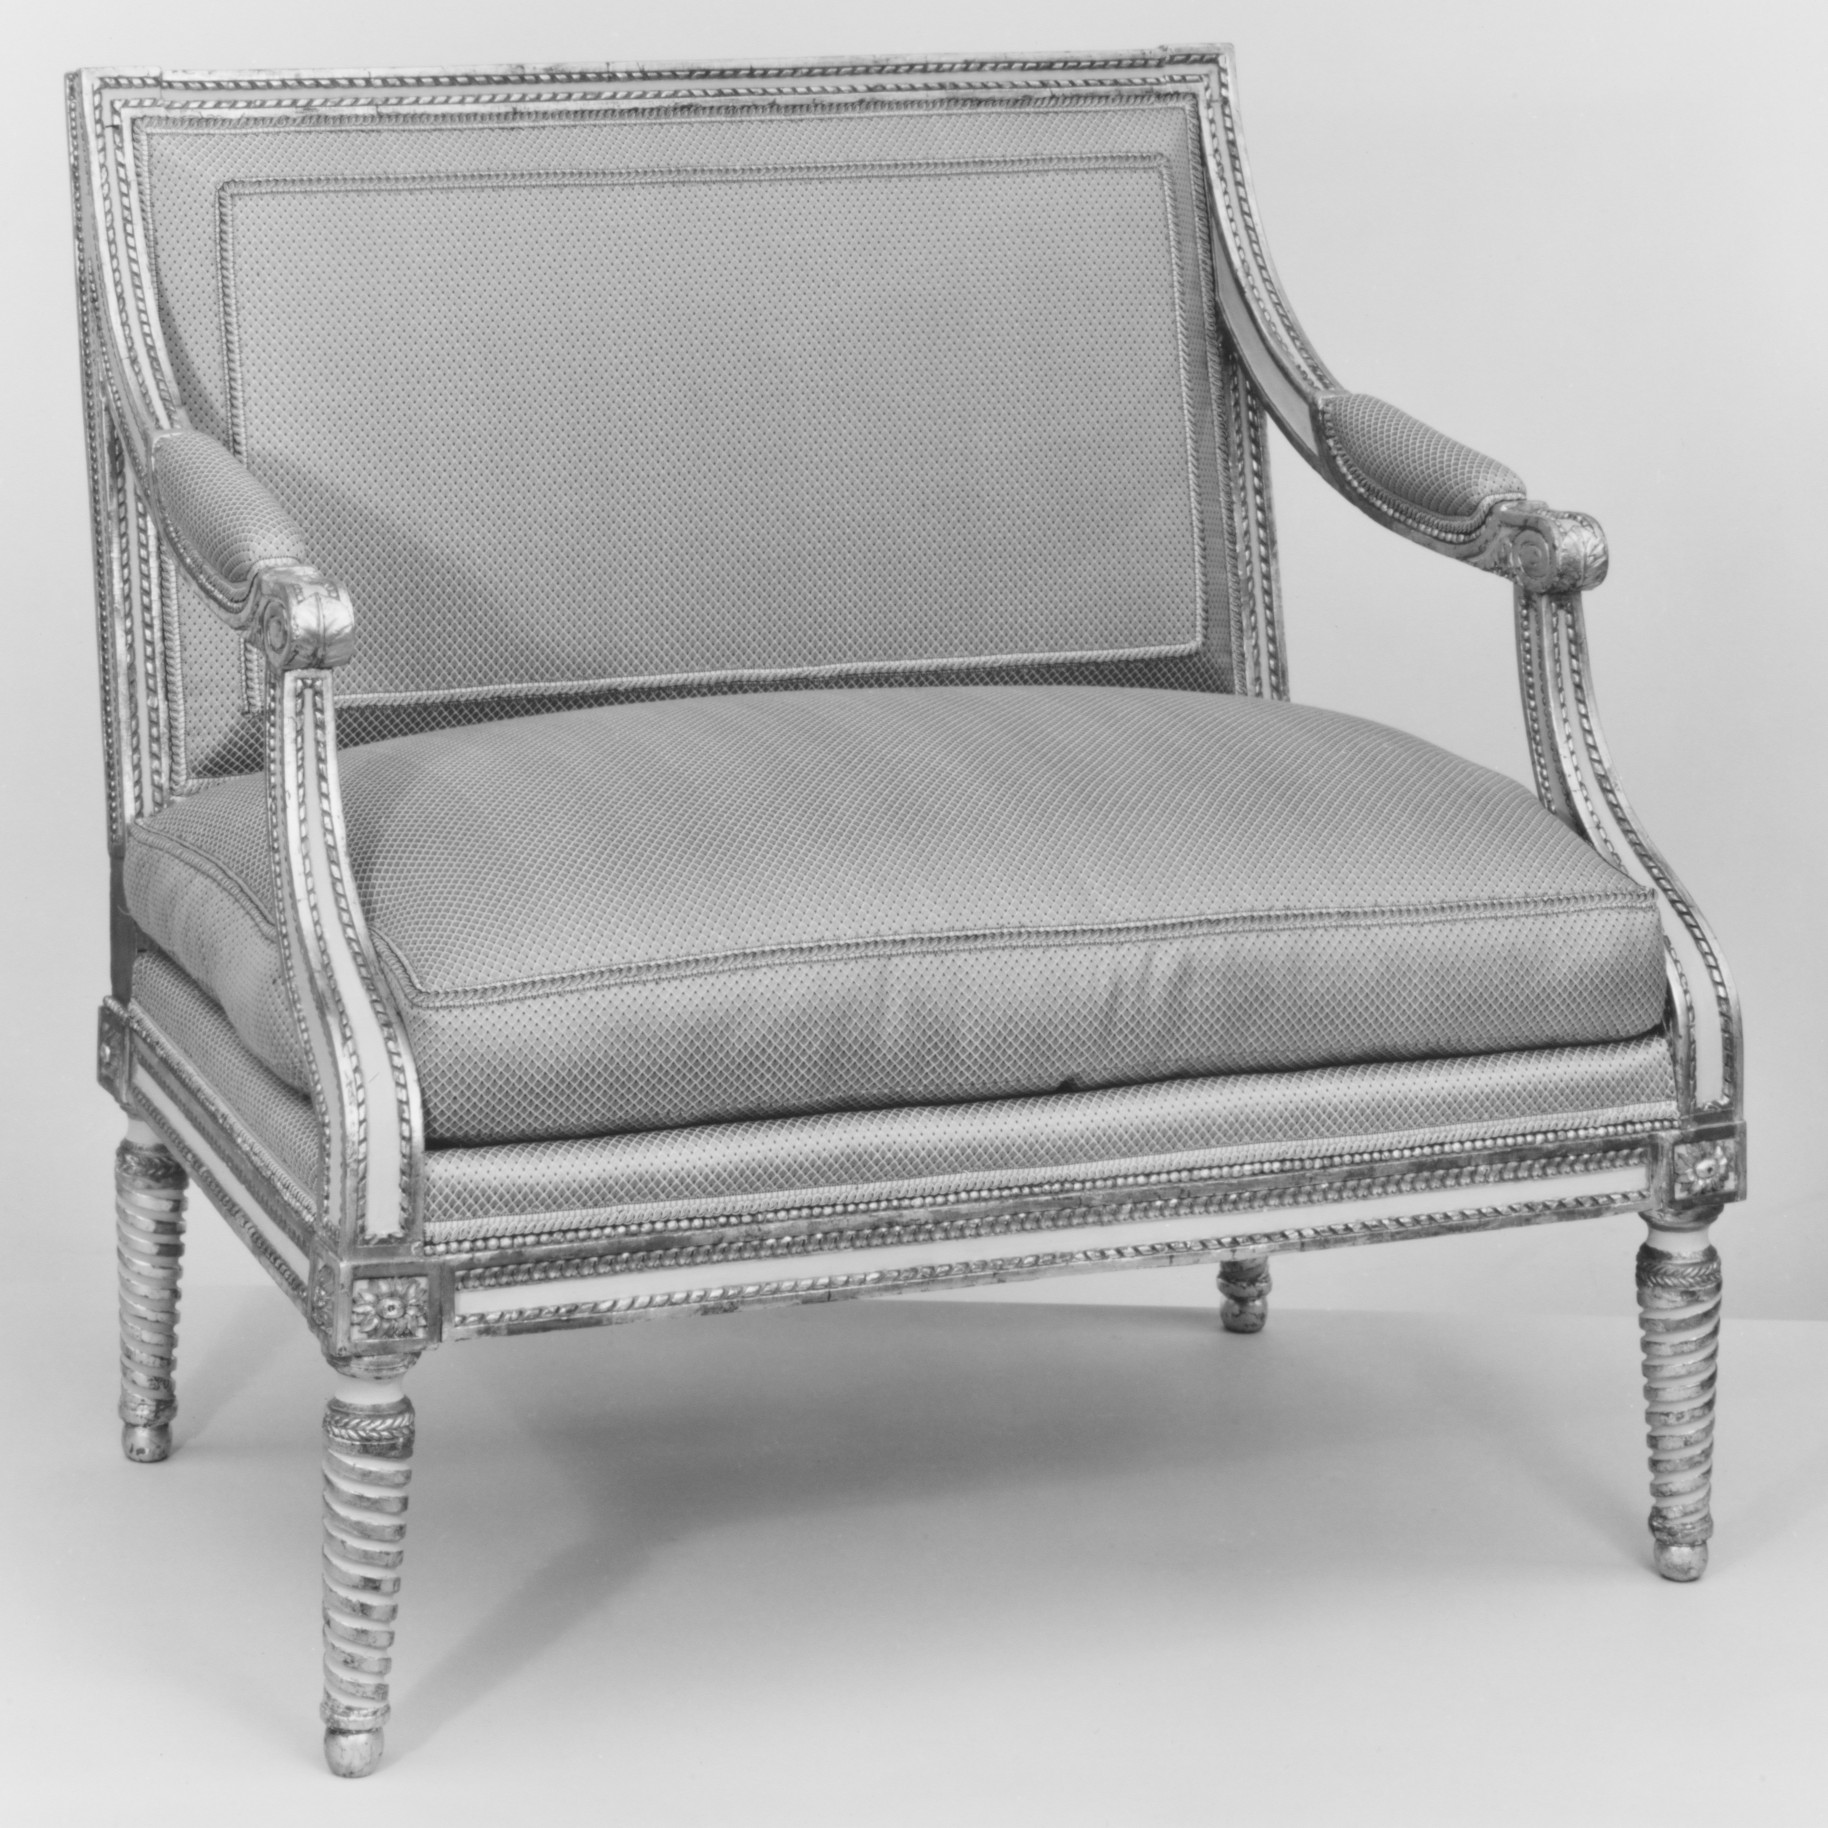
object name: settee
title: Small settee (marquise)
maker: sulpice brizard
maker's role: maker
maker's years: 1735-1798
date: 1775-1780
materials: wood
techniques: carving, gilding